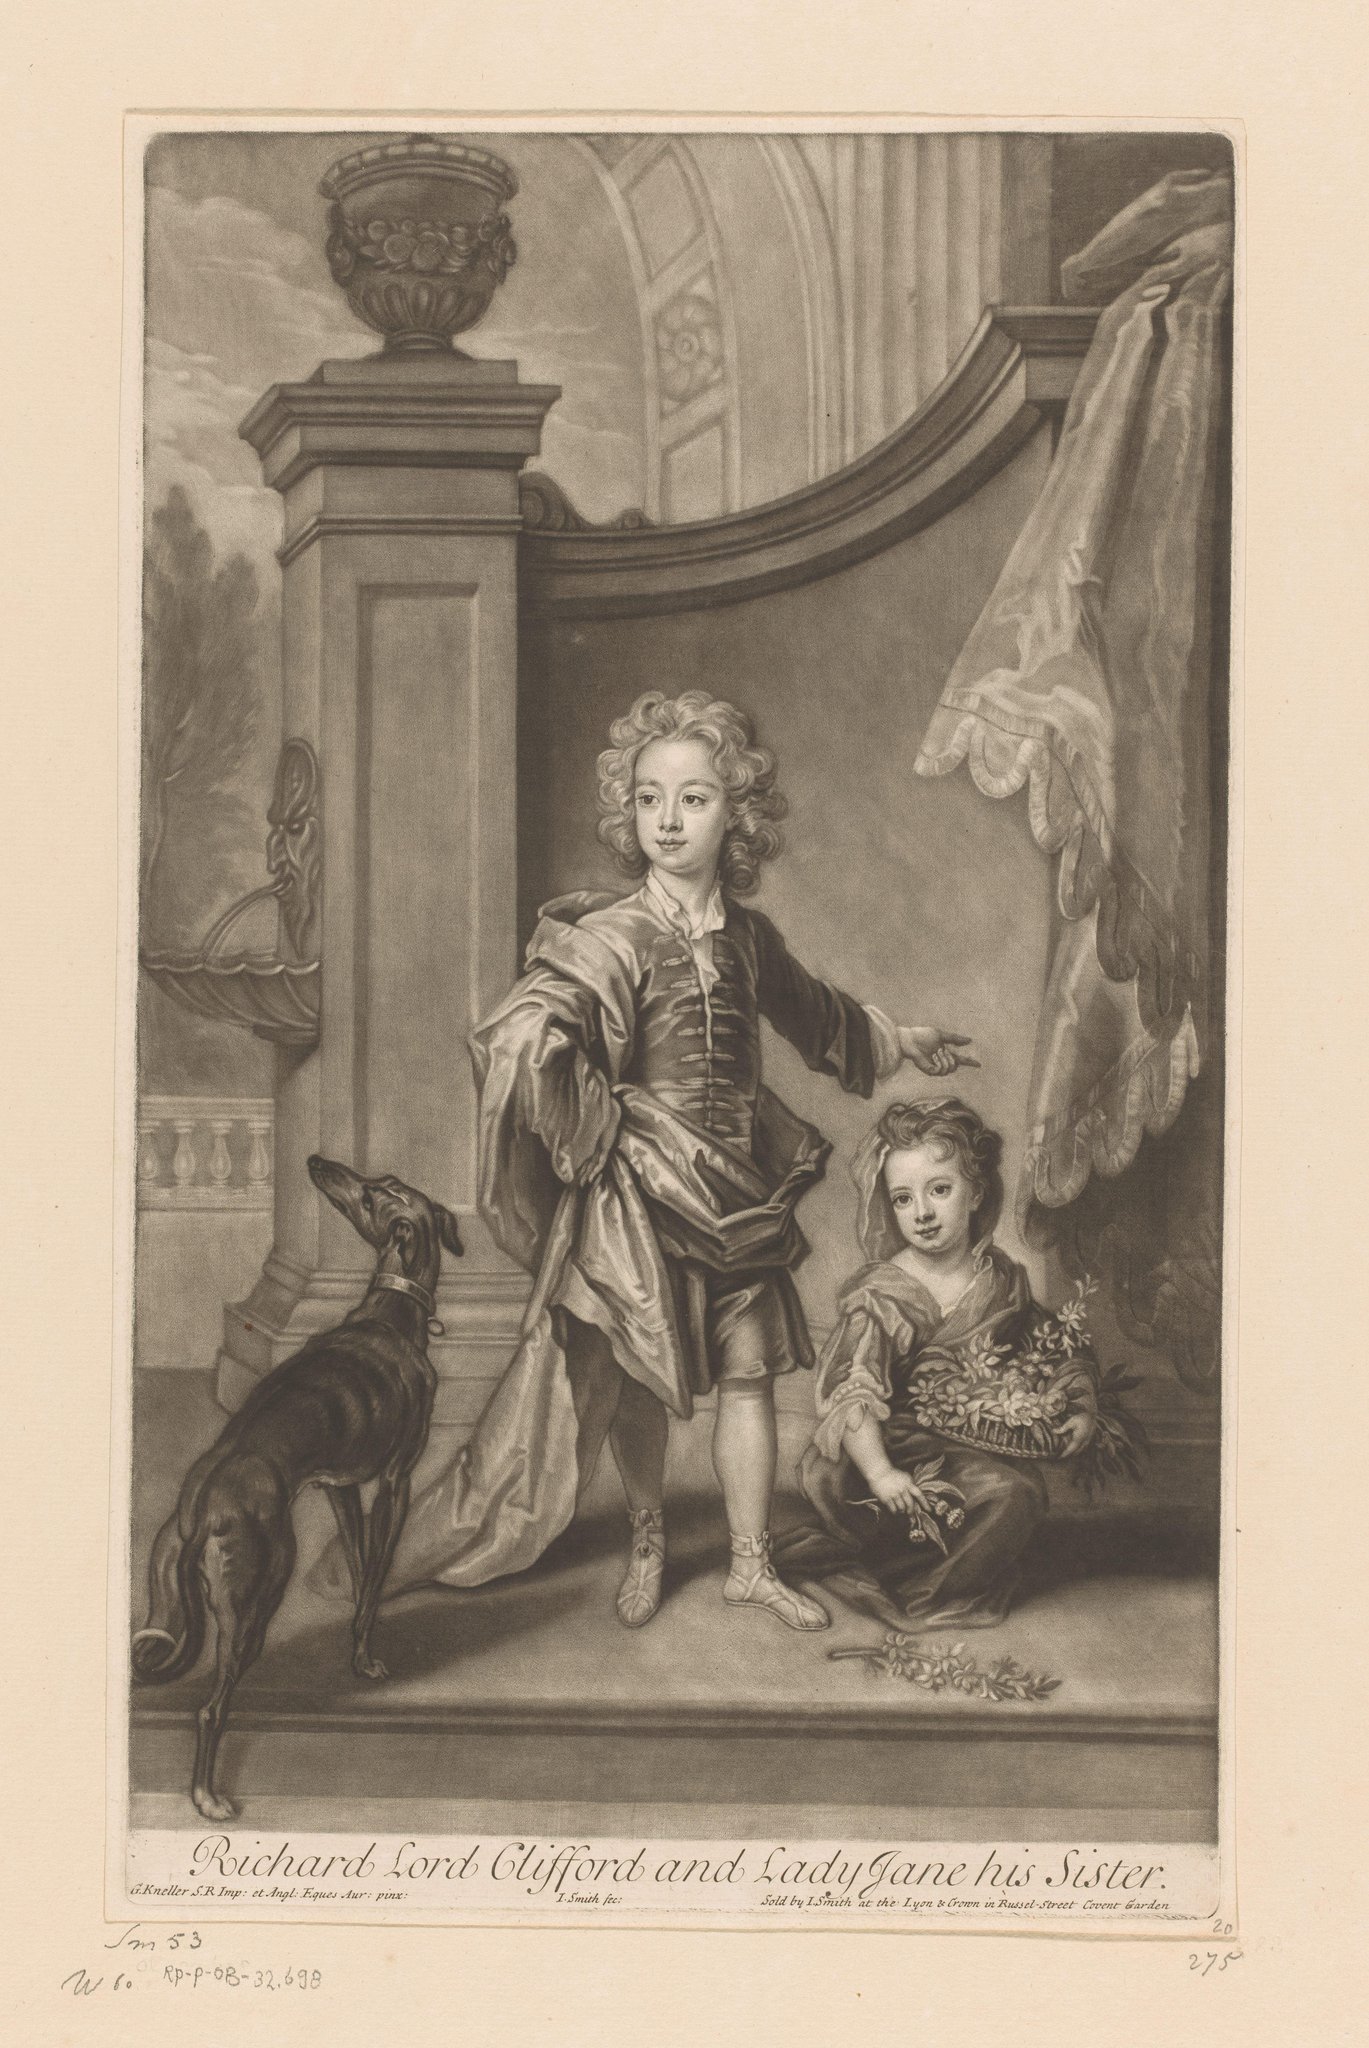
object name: print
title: Portret van Jane en Richard Boyle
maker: john smith (prentmaker/ uitgever)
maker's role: print maker, publisher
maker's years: 1652-1743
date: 1694-1742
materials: paper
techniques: mezzotint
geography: london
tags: politician, richard boyle (3e graaf van burlington), historical persons, dog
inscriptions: collector's mark: Lugt 240